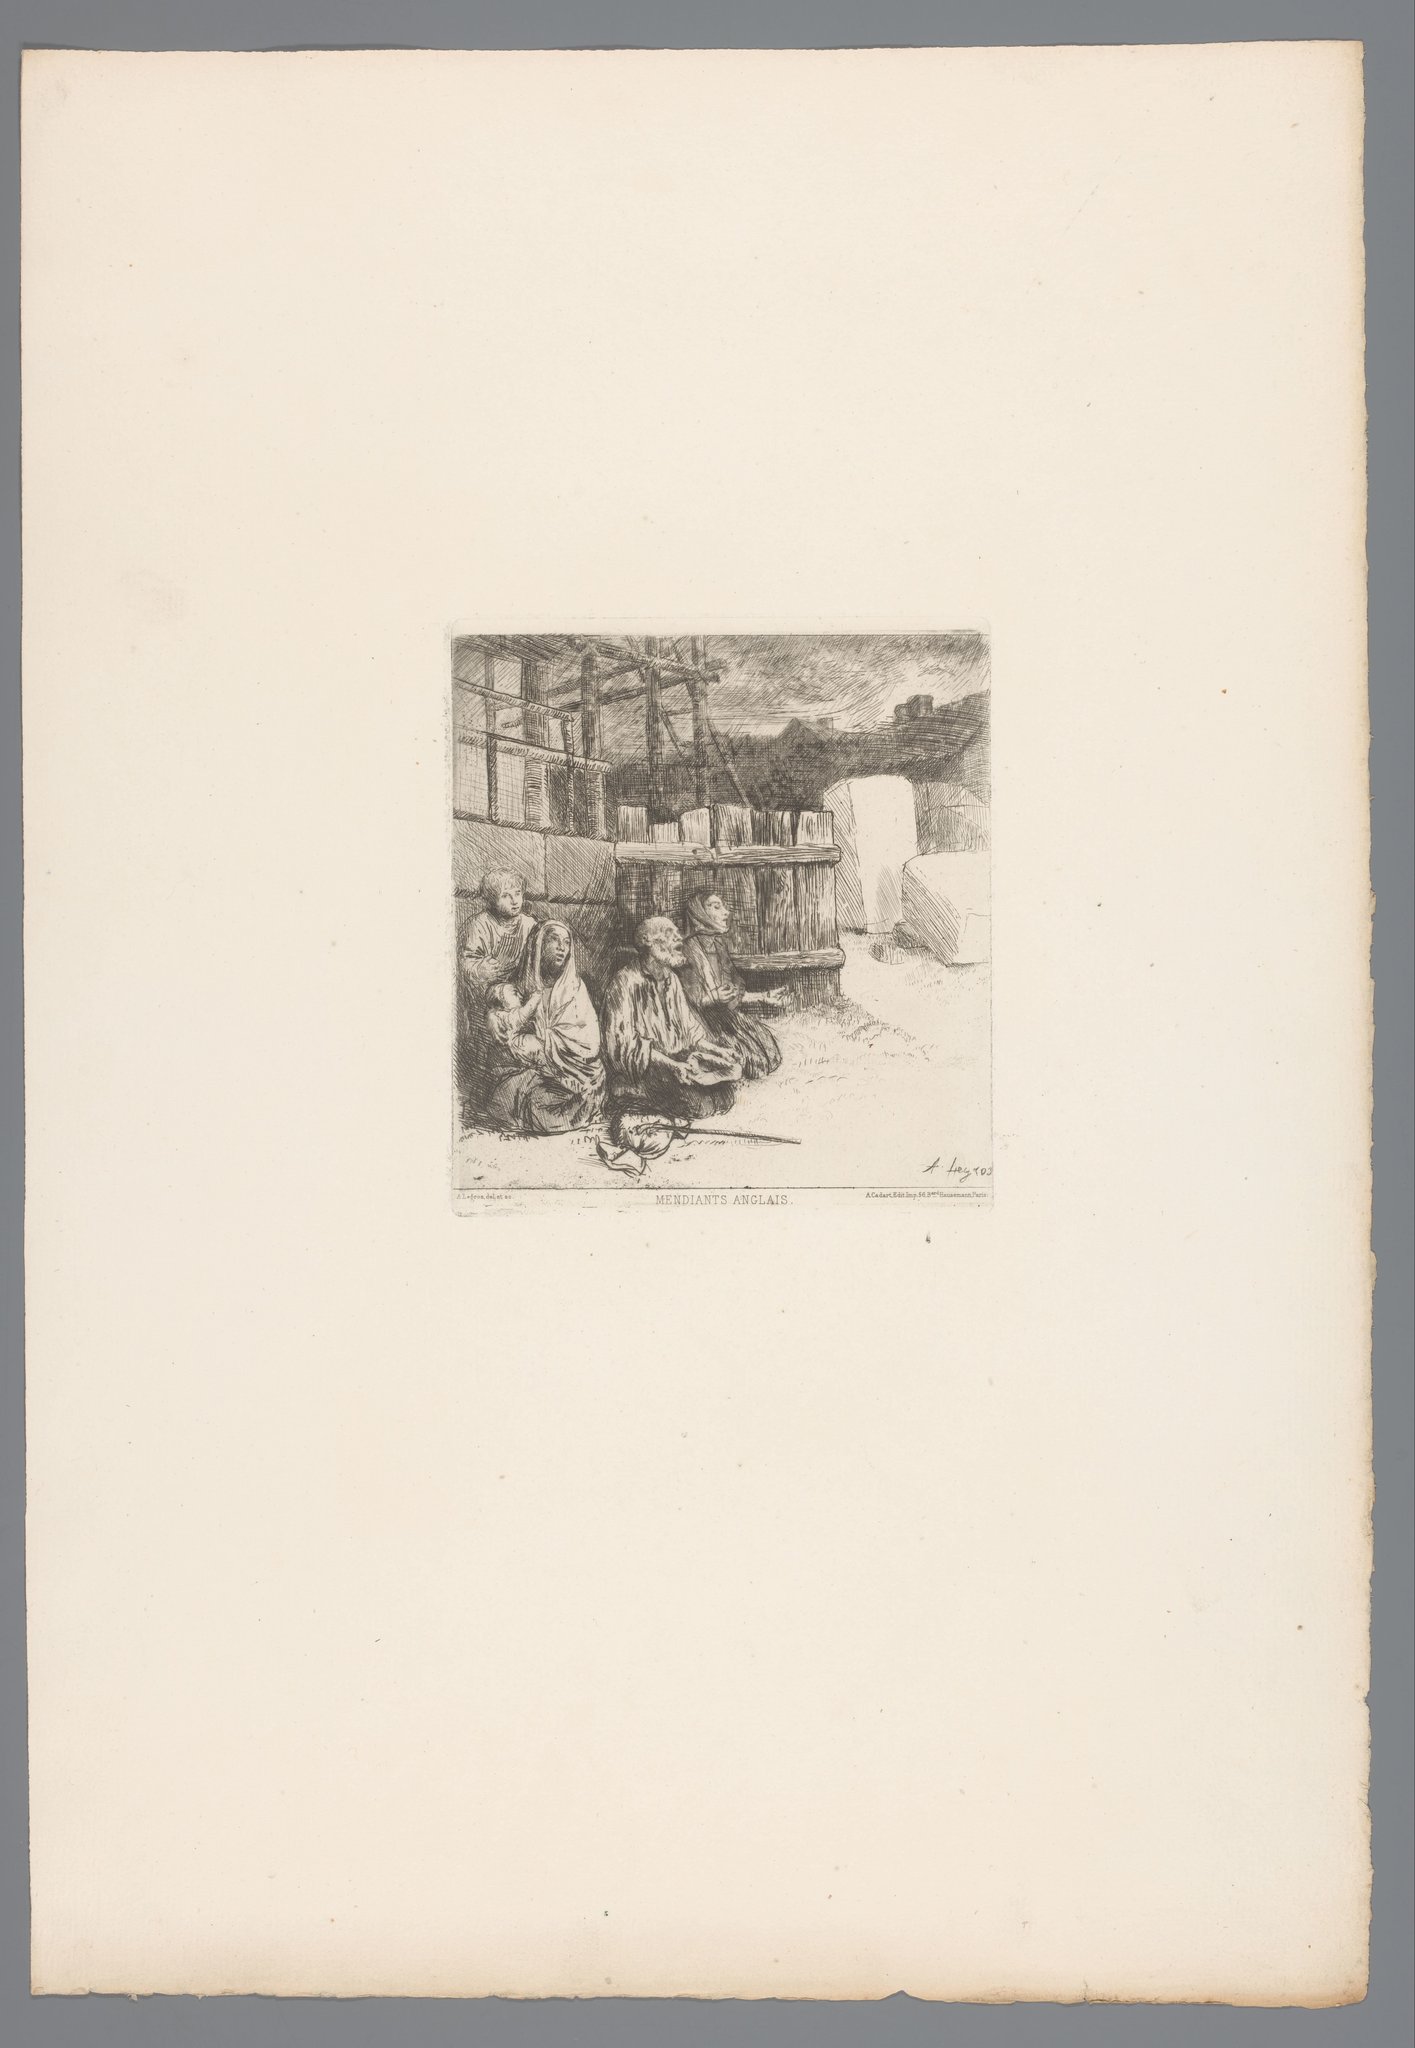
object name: print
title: Groep Engelse bedelaars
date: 1875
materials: paper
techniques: drypoint, etching, intaglio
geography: paris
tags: beggar, england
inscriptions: collector's mark: ‘AFE v S’, collector's mark: Lugt 2228, collector's mark: Lugt 2760